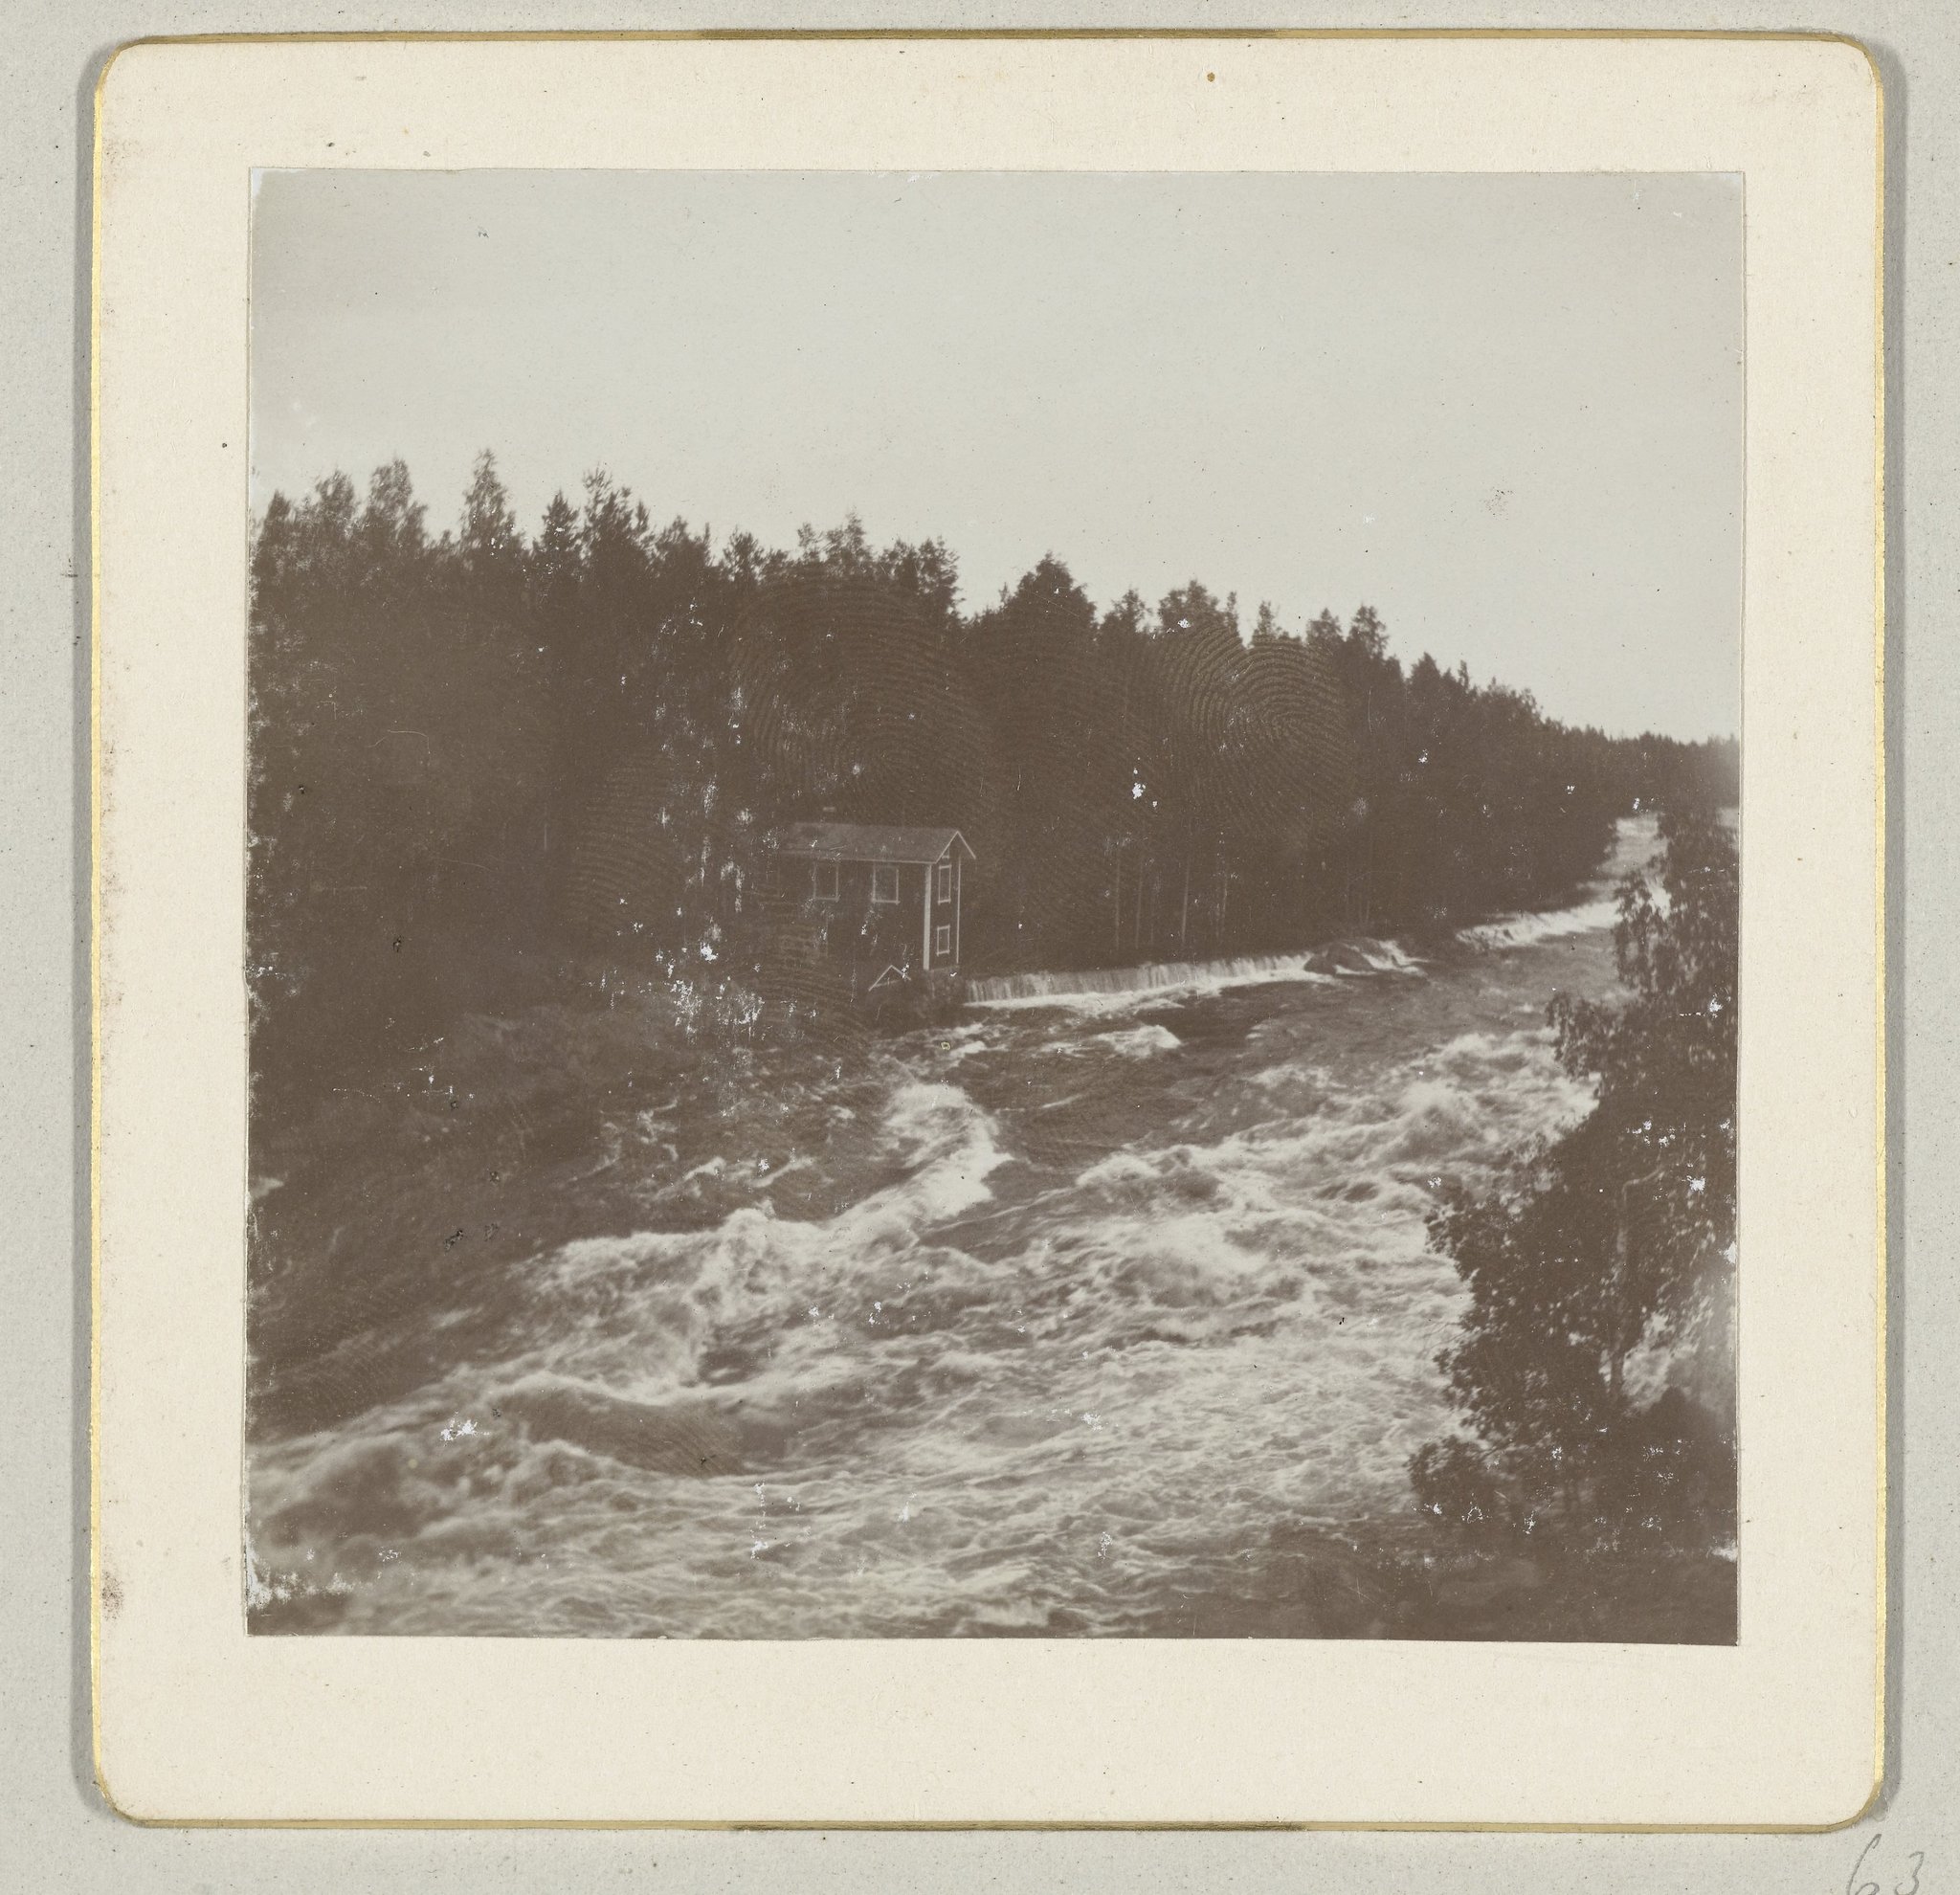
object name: photograph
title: Finland Imatra waterval.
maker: henry pauw van wieldrecht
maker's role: fotograaf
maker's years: 1863-1912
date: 1898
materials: paper, photographic support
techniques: albumen print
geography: helsinki